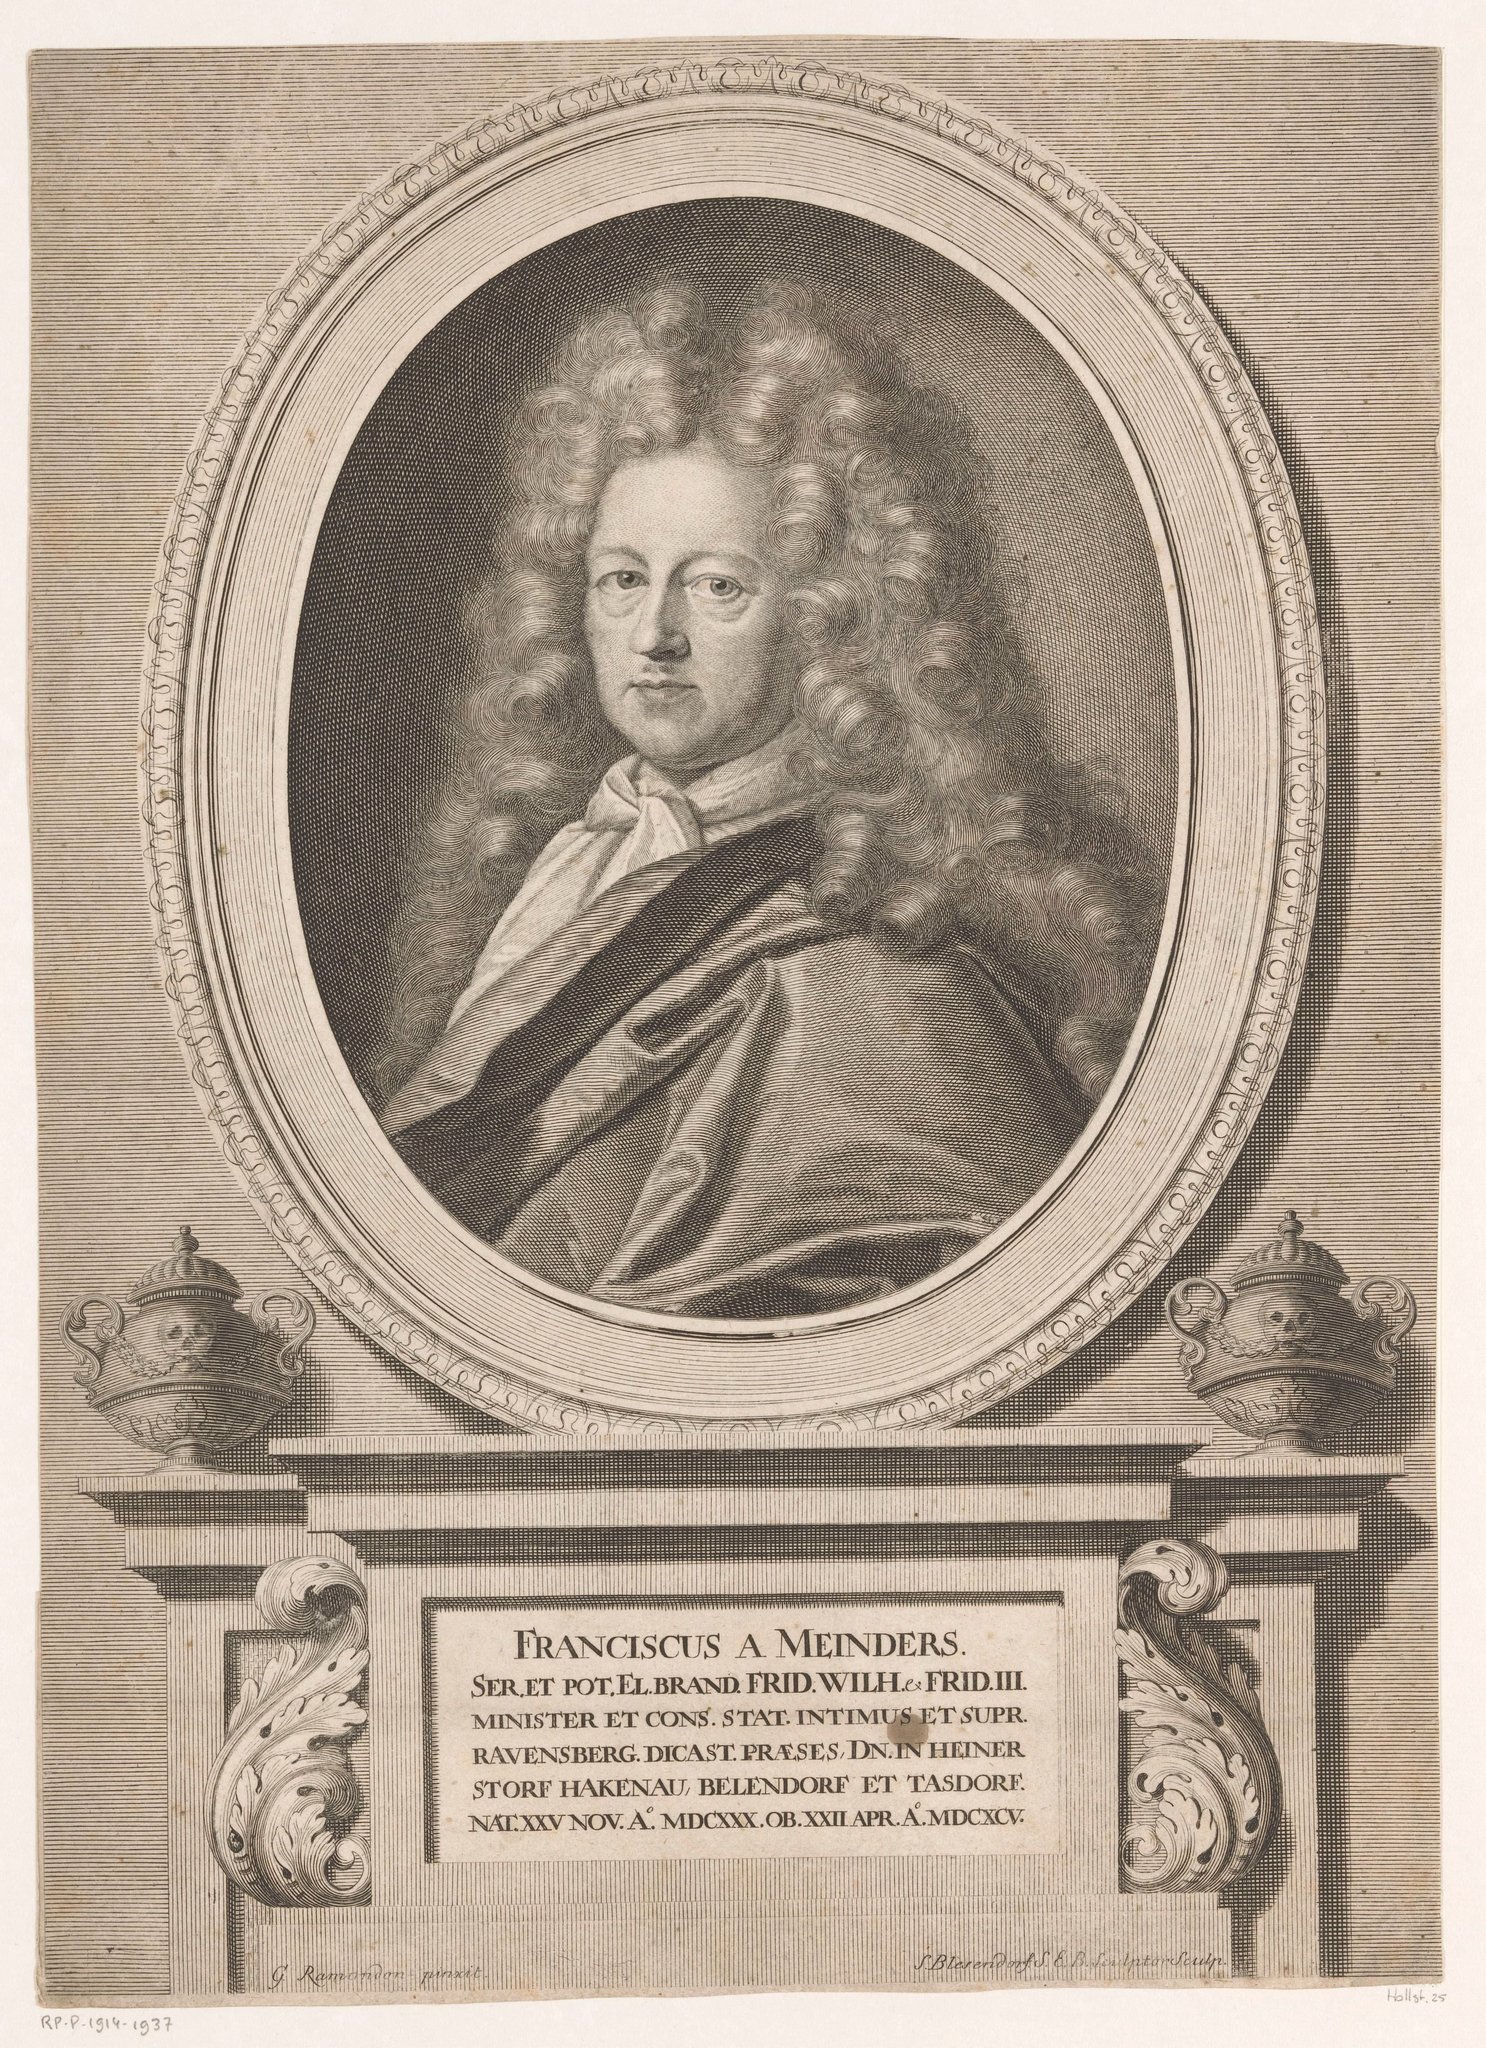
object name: print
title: Portret van Franz von Meinders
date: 1695-1706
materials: paper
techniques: engraving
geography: berlin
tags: berlin, historical persons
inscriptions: collector's mark: Lugt 2228